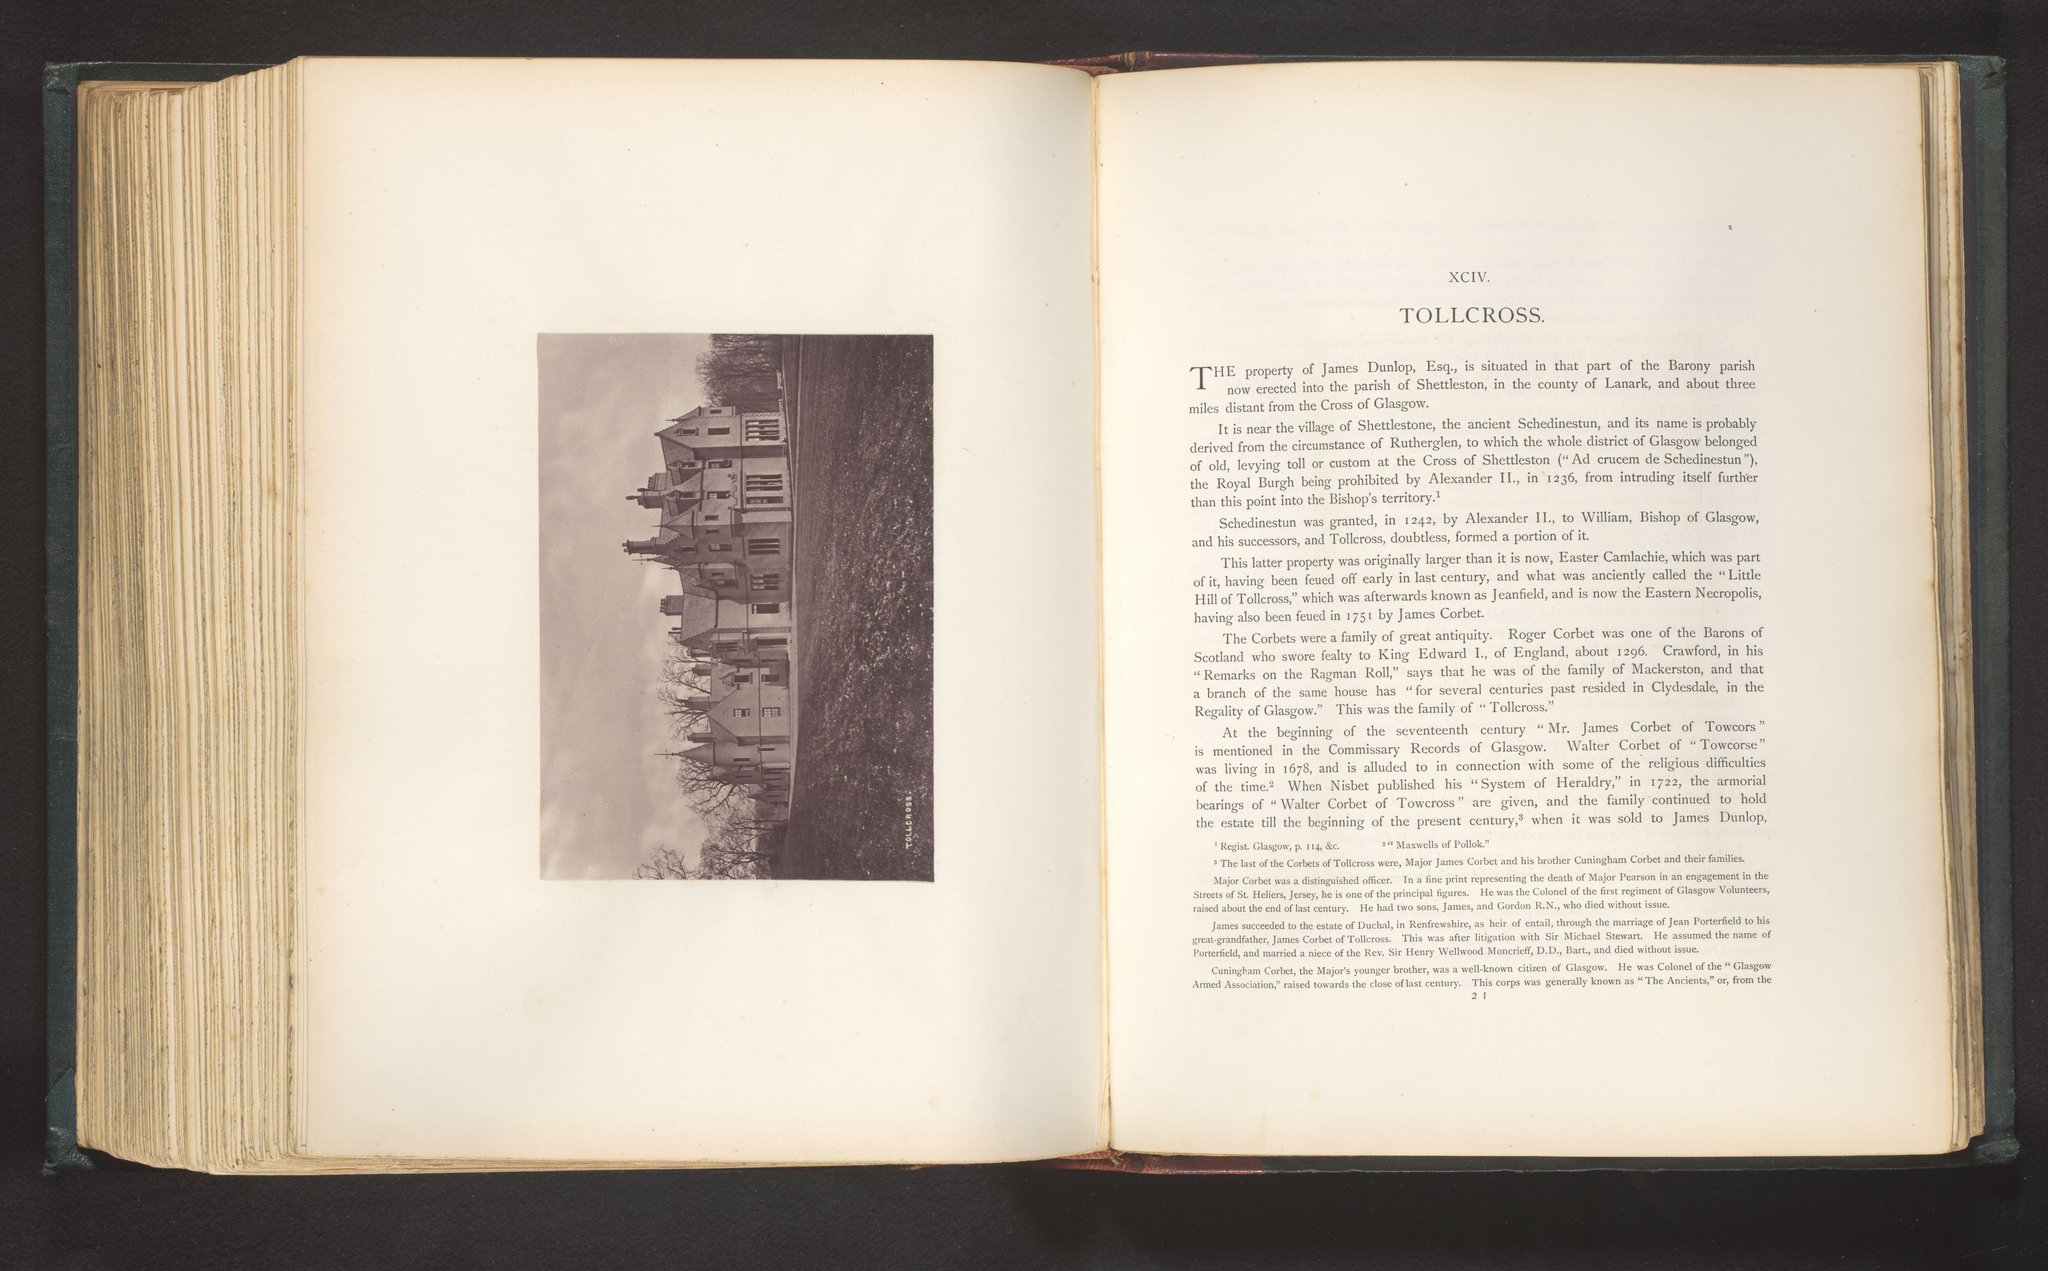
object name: page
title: Tollcross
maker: thomas annan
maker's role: fotograaf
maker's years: 1829-1887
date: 1868-1878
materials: paper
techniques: carbon print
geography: glasgow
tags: rural housing, e.g. country-house, villa, cottage, façade (of house or building)